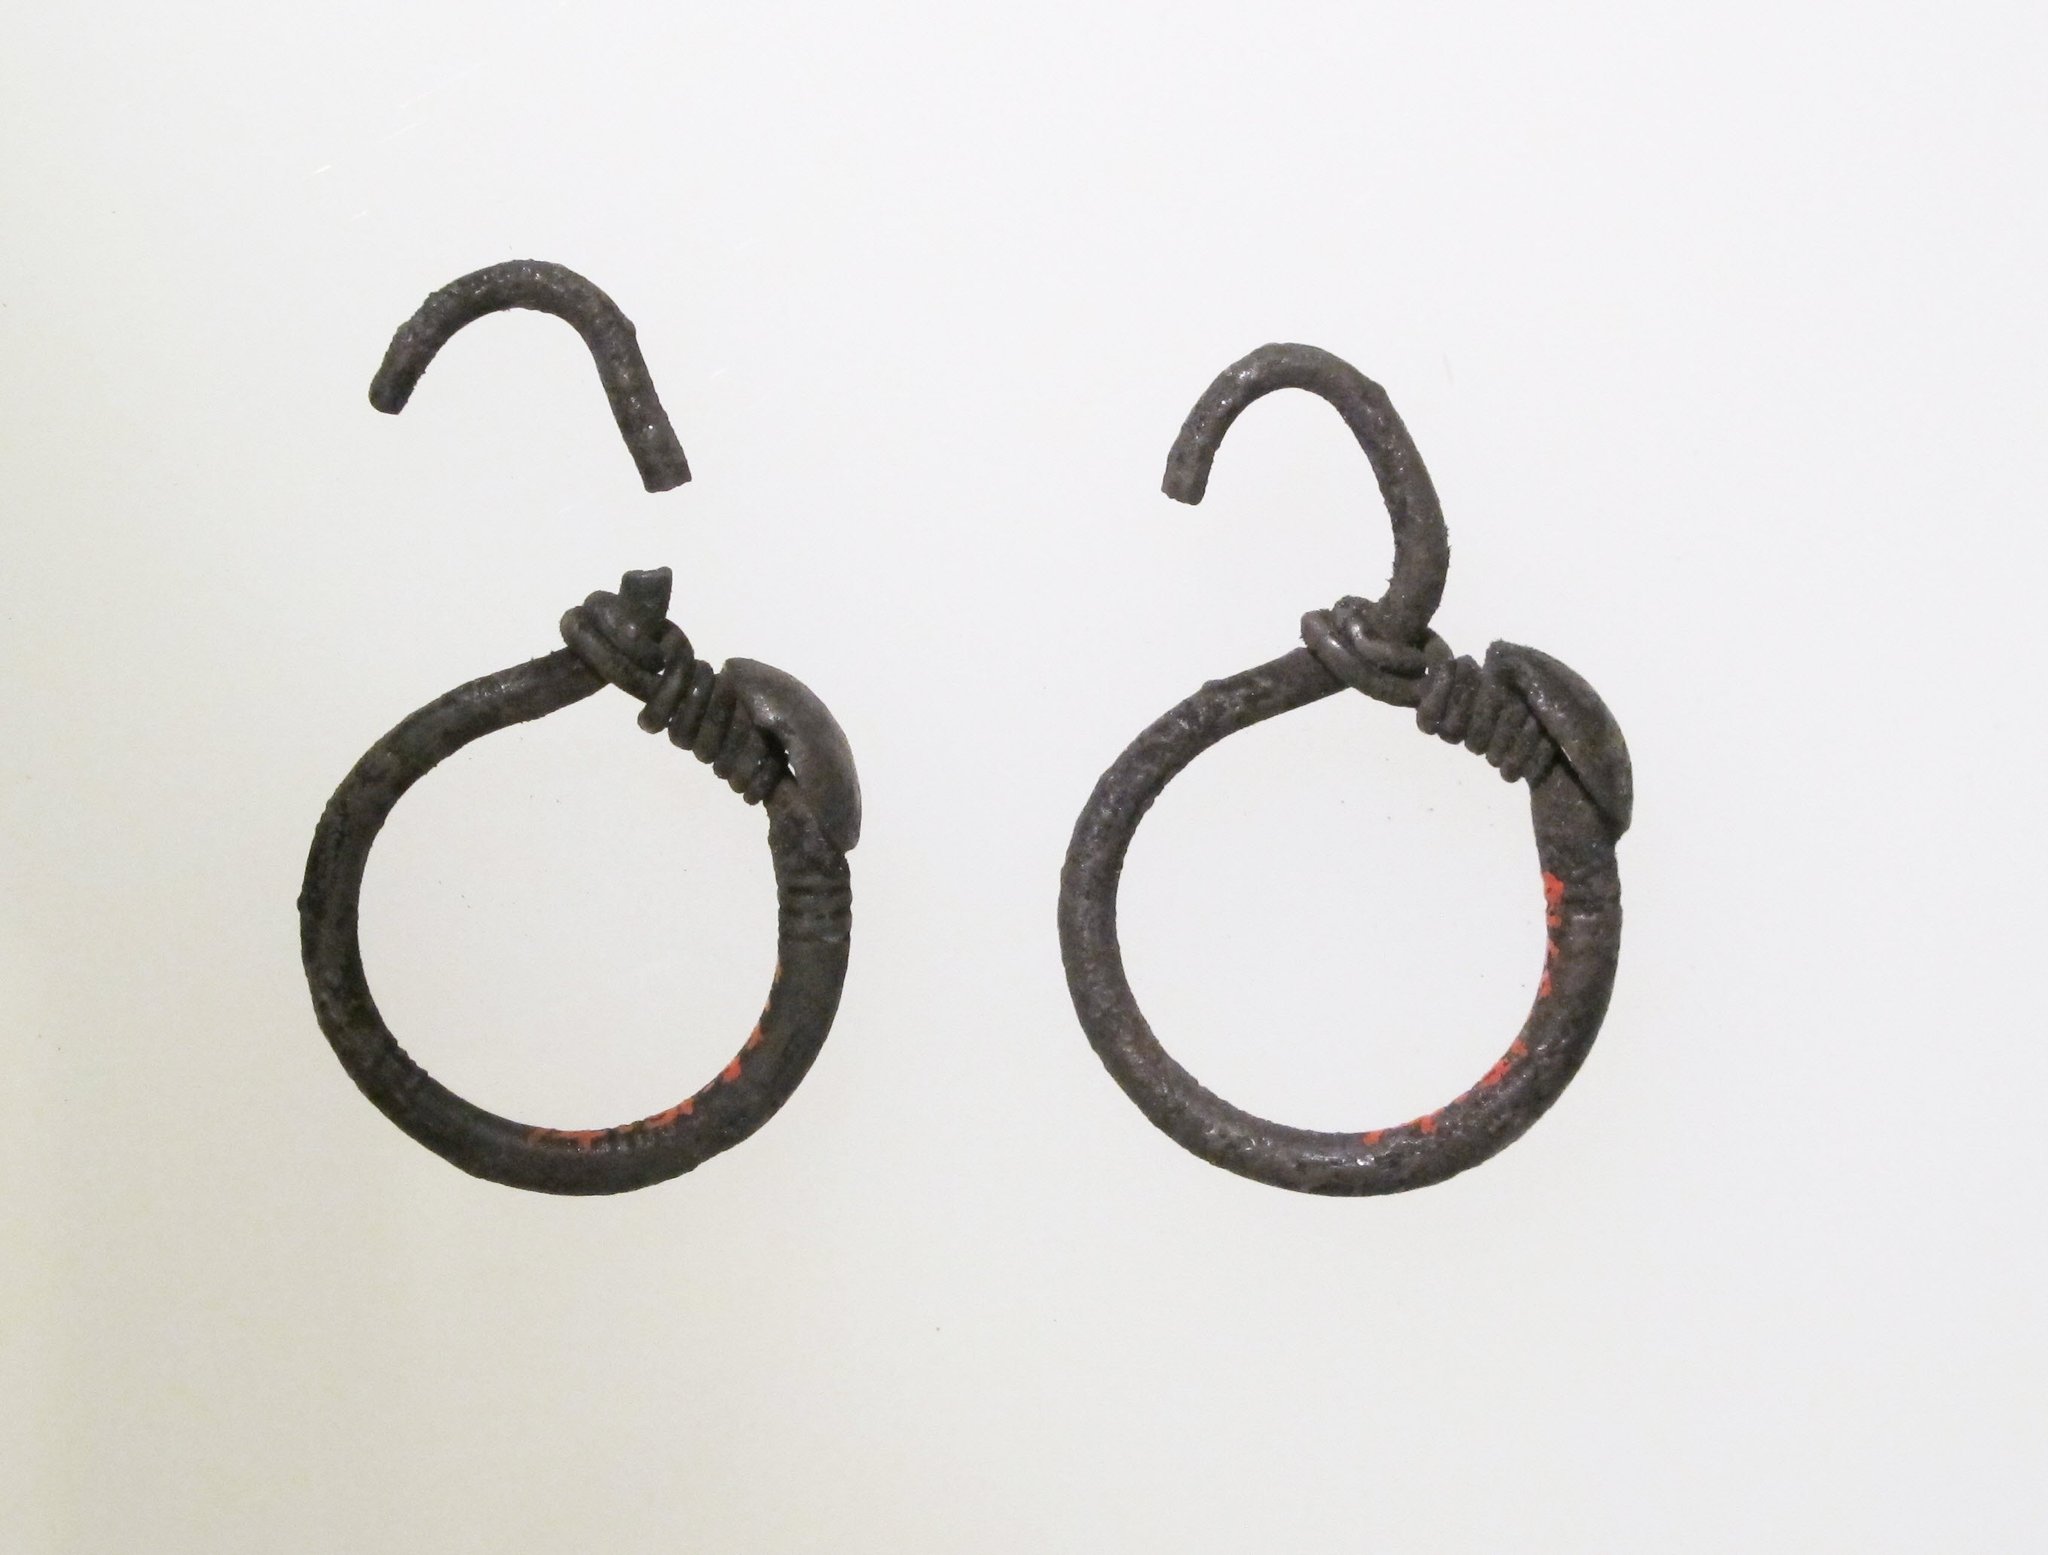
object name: earring, delta shaped with disc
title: Earring, delta-shaped with disc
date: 7000 BCE-330 CE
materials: silver